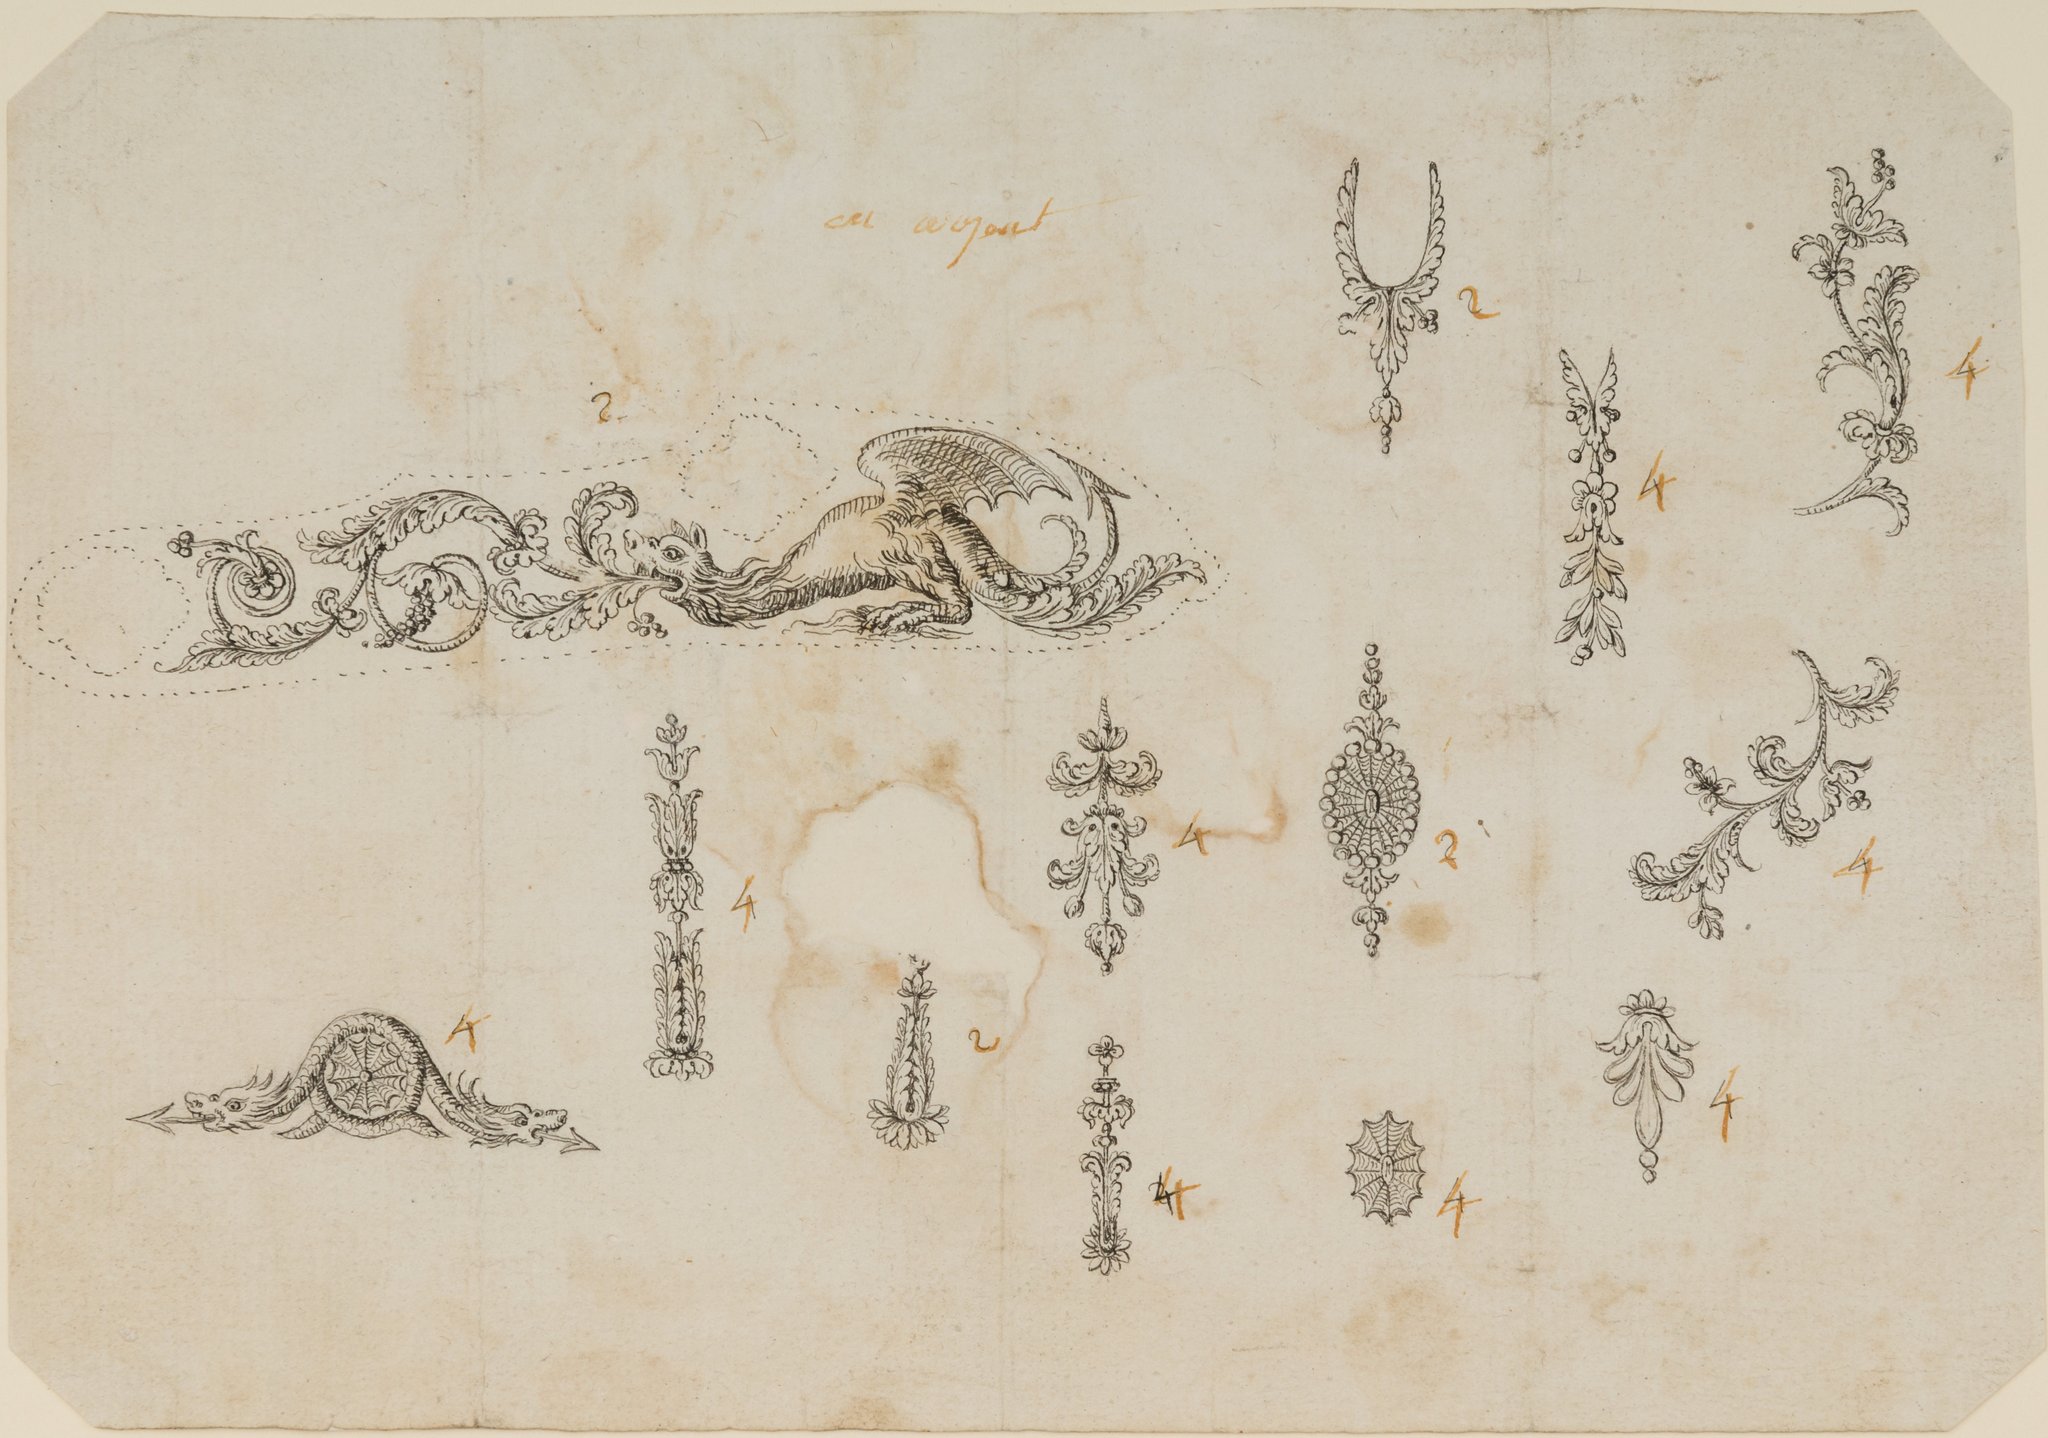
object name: drawing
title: Thirteen Designs for the Decoration of Firearms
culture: french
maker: nicolas noël boutet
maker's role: designer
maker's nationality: french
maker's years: 1761-1833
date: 1797-1805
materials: ink, paper, pencil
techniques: wash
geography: france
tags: ornament